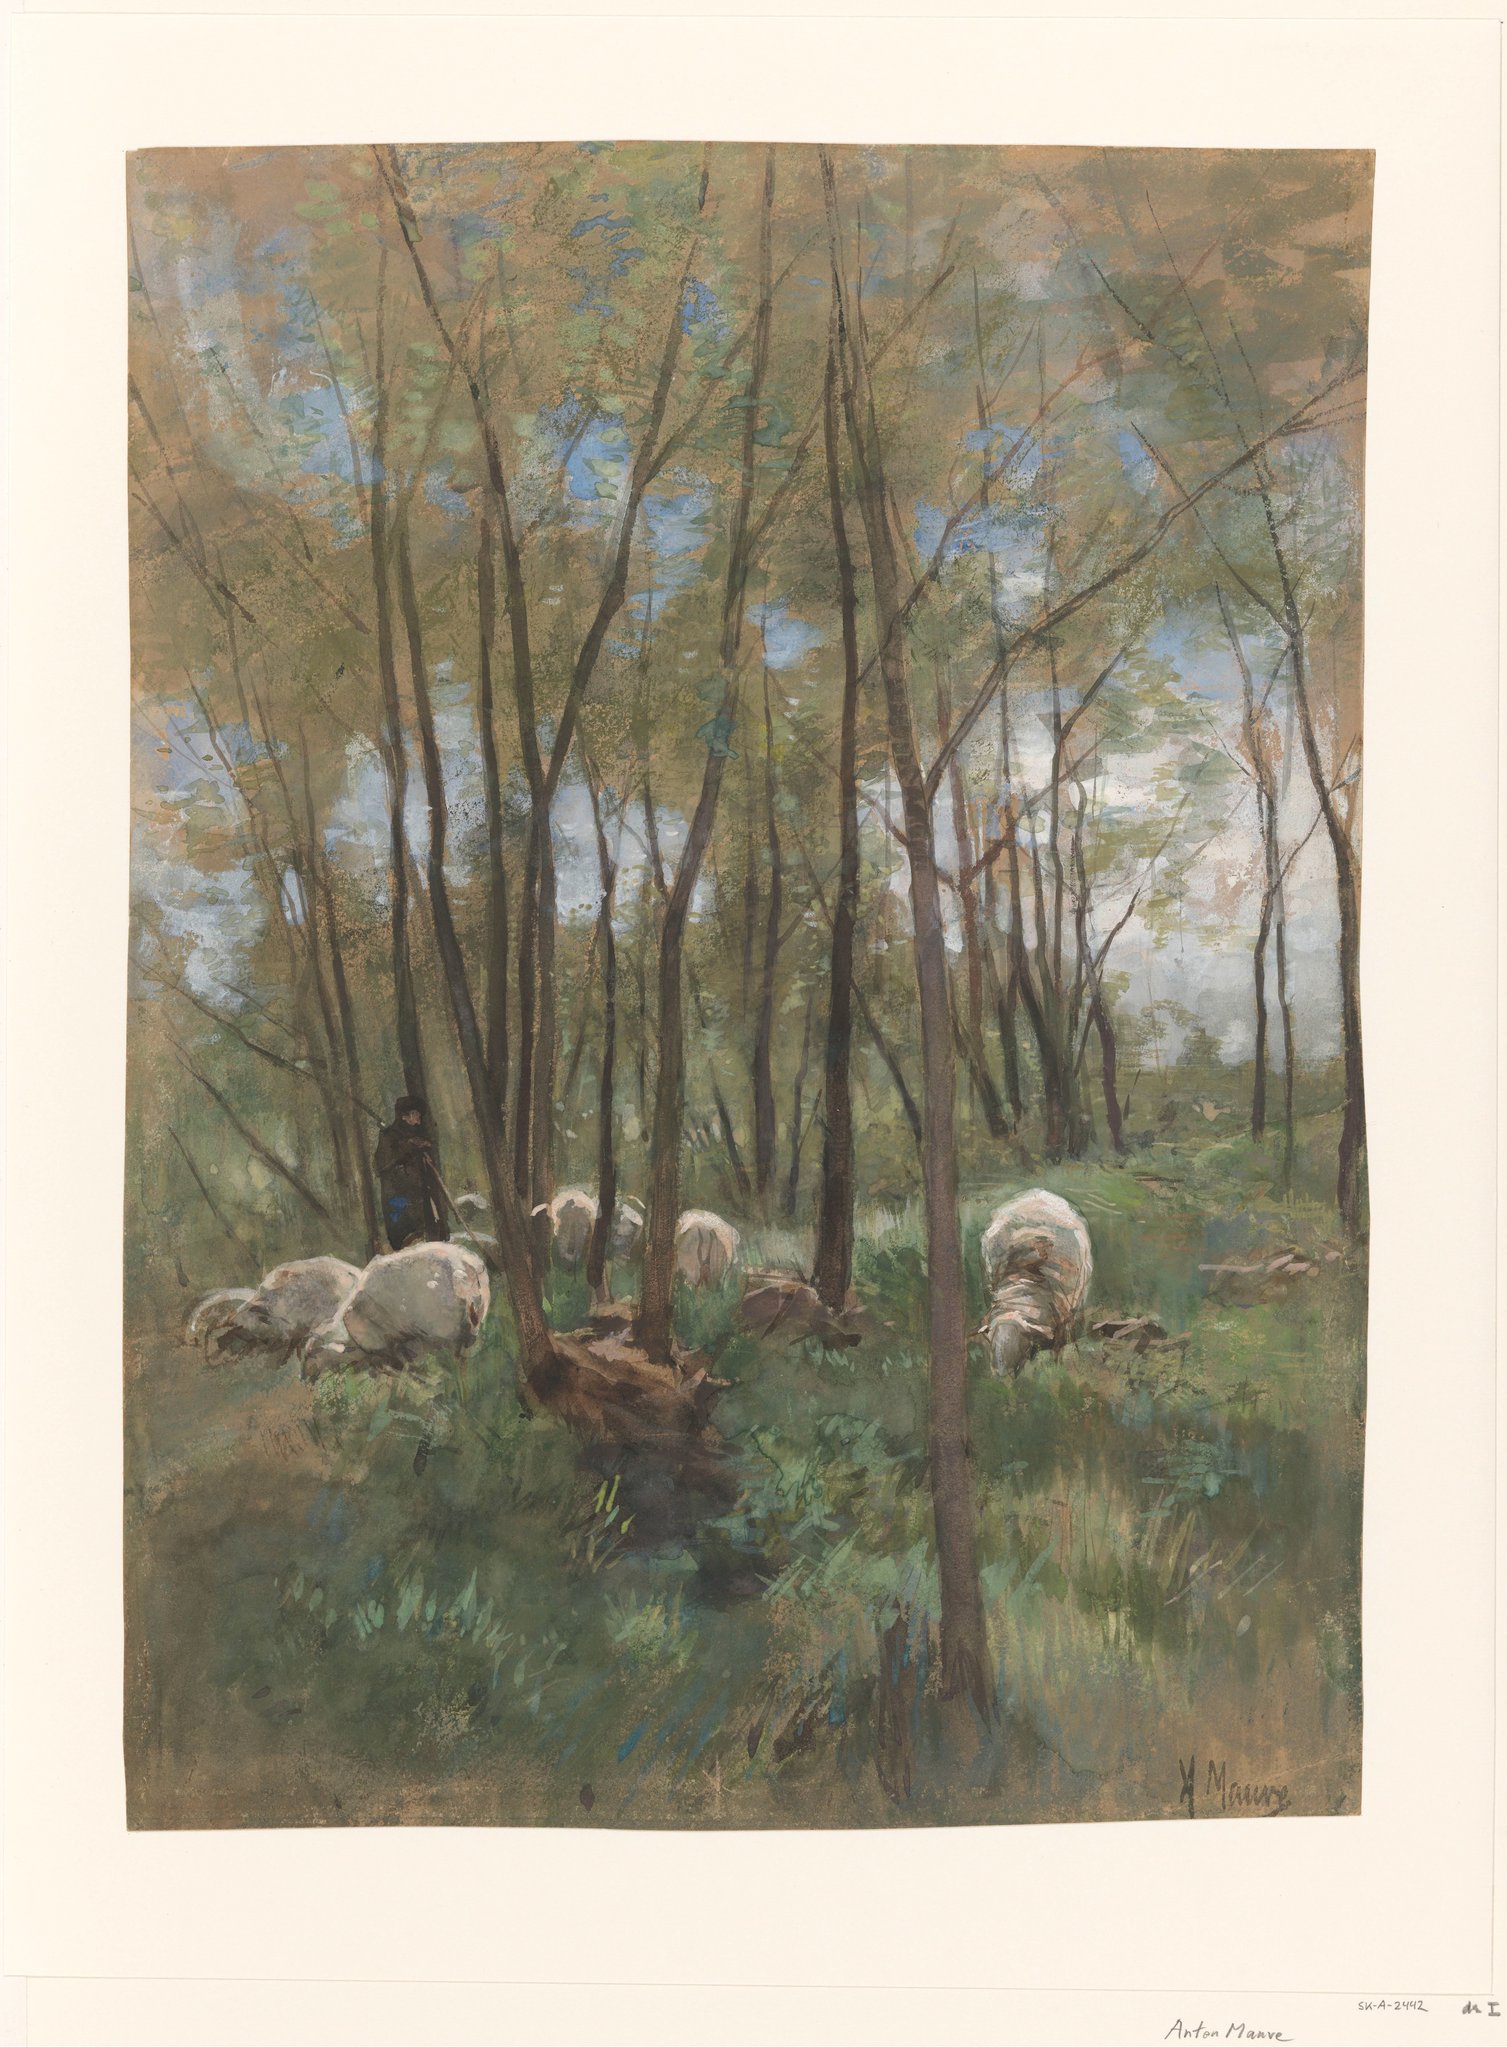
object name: drawing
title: Schapenkudde in een bos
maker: anton mauve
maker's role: draughtsman, painter, print maker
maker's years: 1838-1888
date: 1848-1888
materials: paper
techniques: brush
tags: sheep, herd, flock